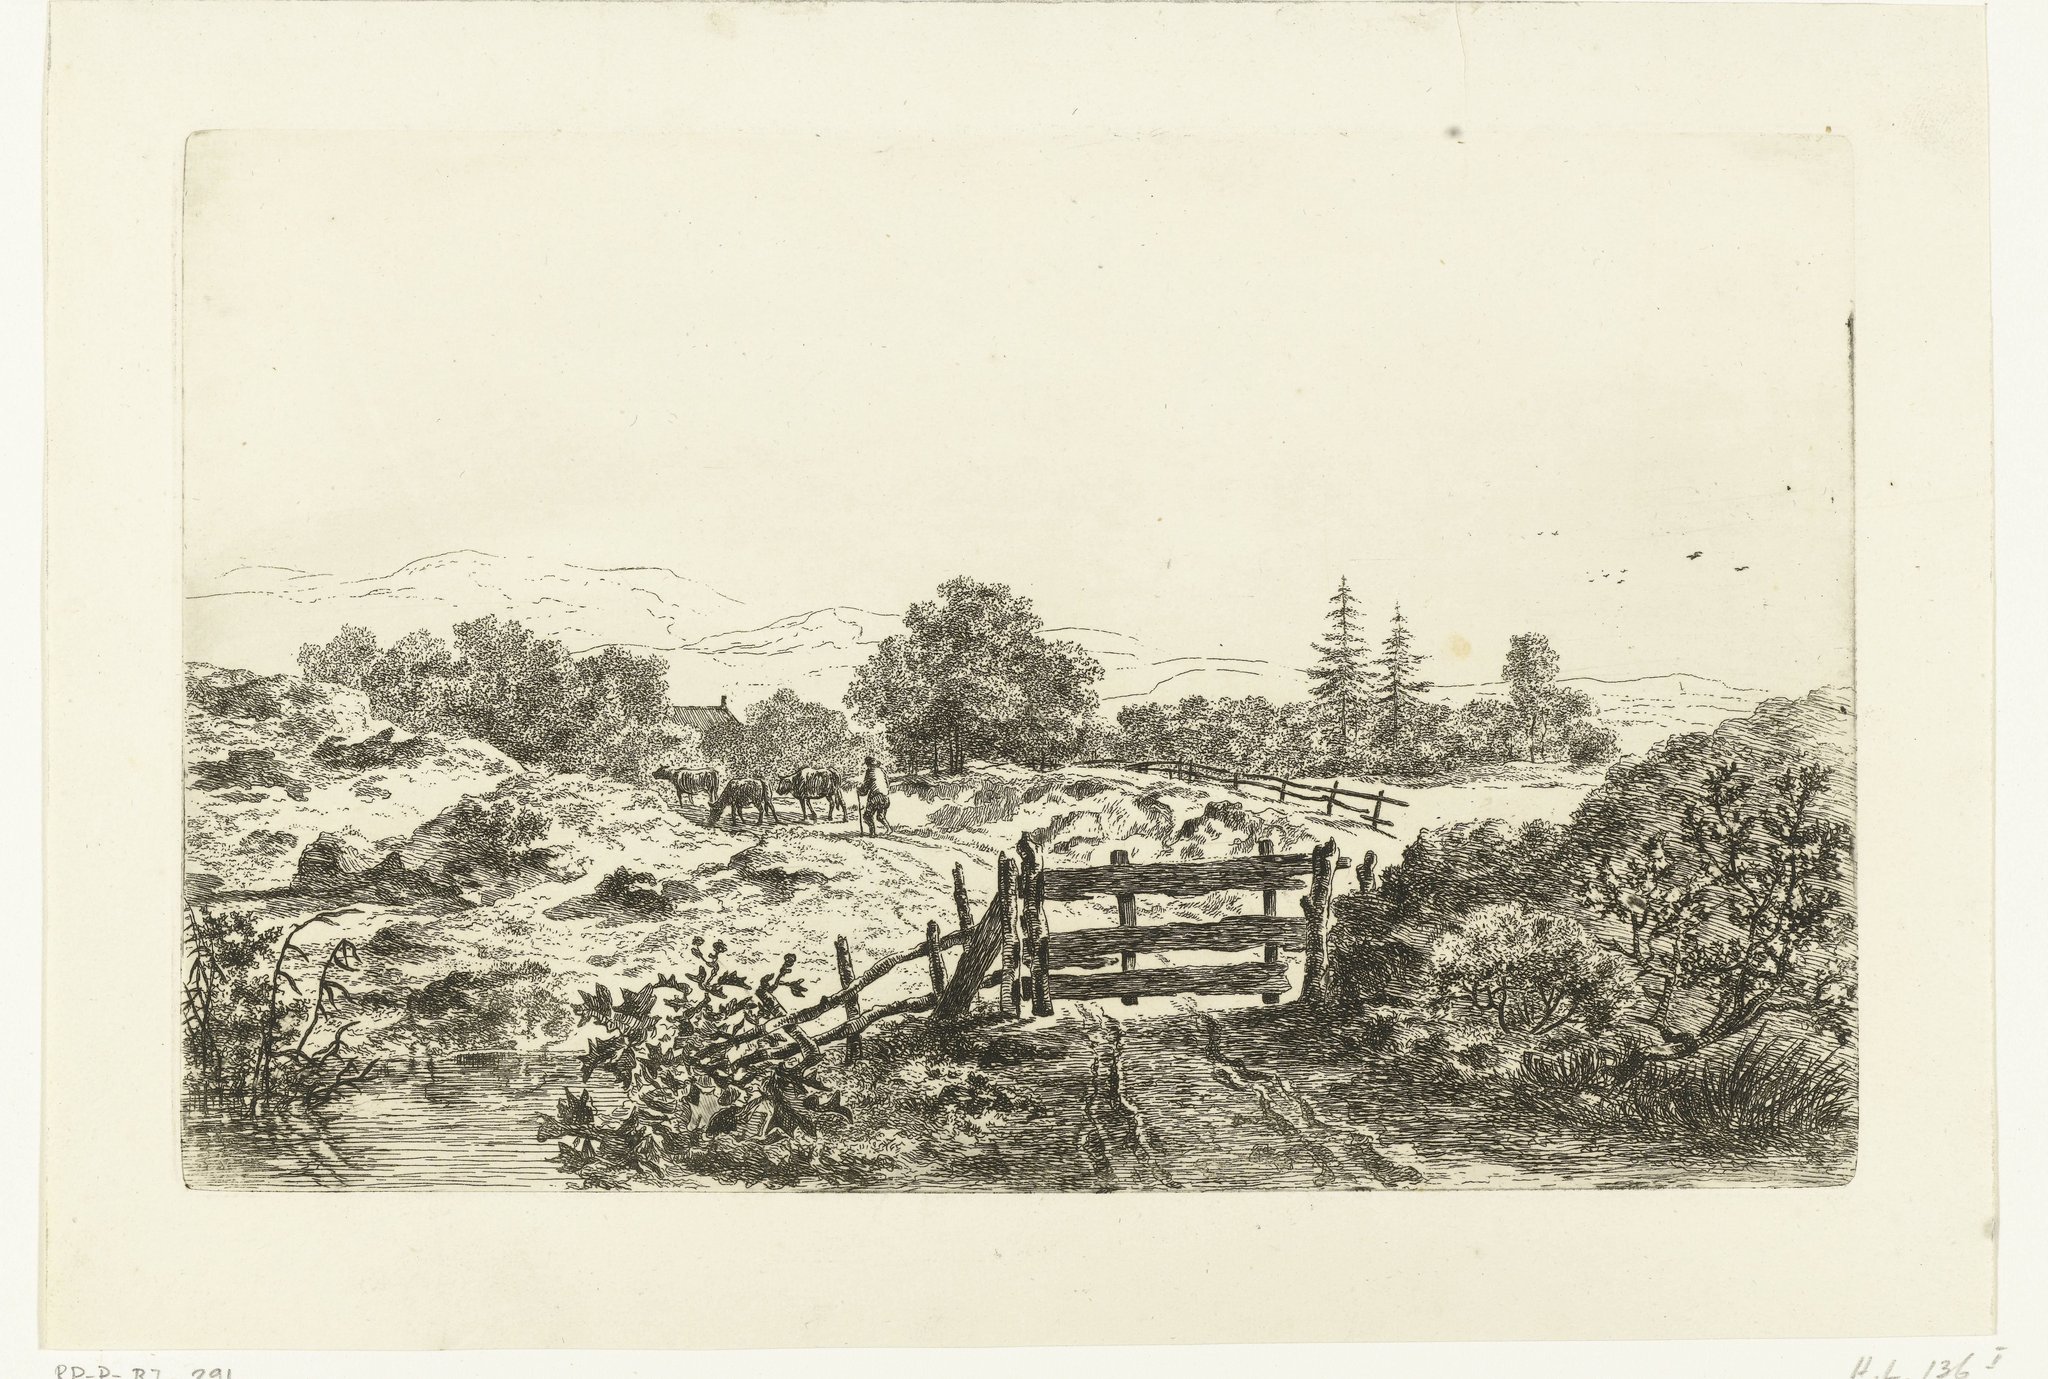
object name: print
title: Een herder met koeien op de weg naar Waalsdorp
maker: ernst willem jan bagelaar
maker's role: draughtsman, print maker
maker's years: 1775-1837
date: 1798-1837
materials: paper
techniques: etching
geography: netherlands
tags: herding, herdsman, herdswoman, shepherd, shepherdess, cowherd, etc.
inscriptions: collector's mark: Lugt 2228